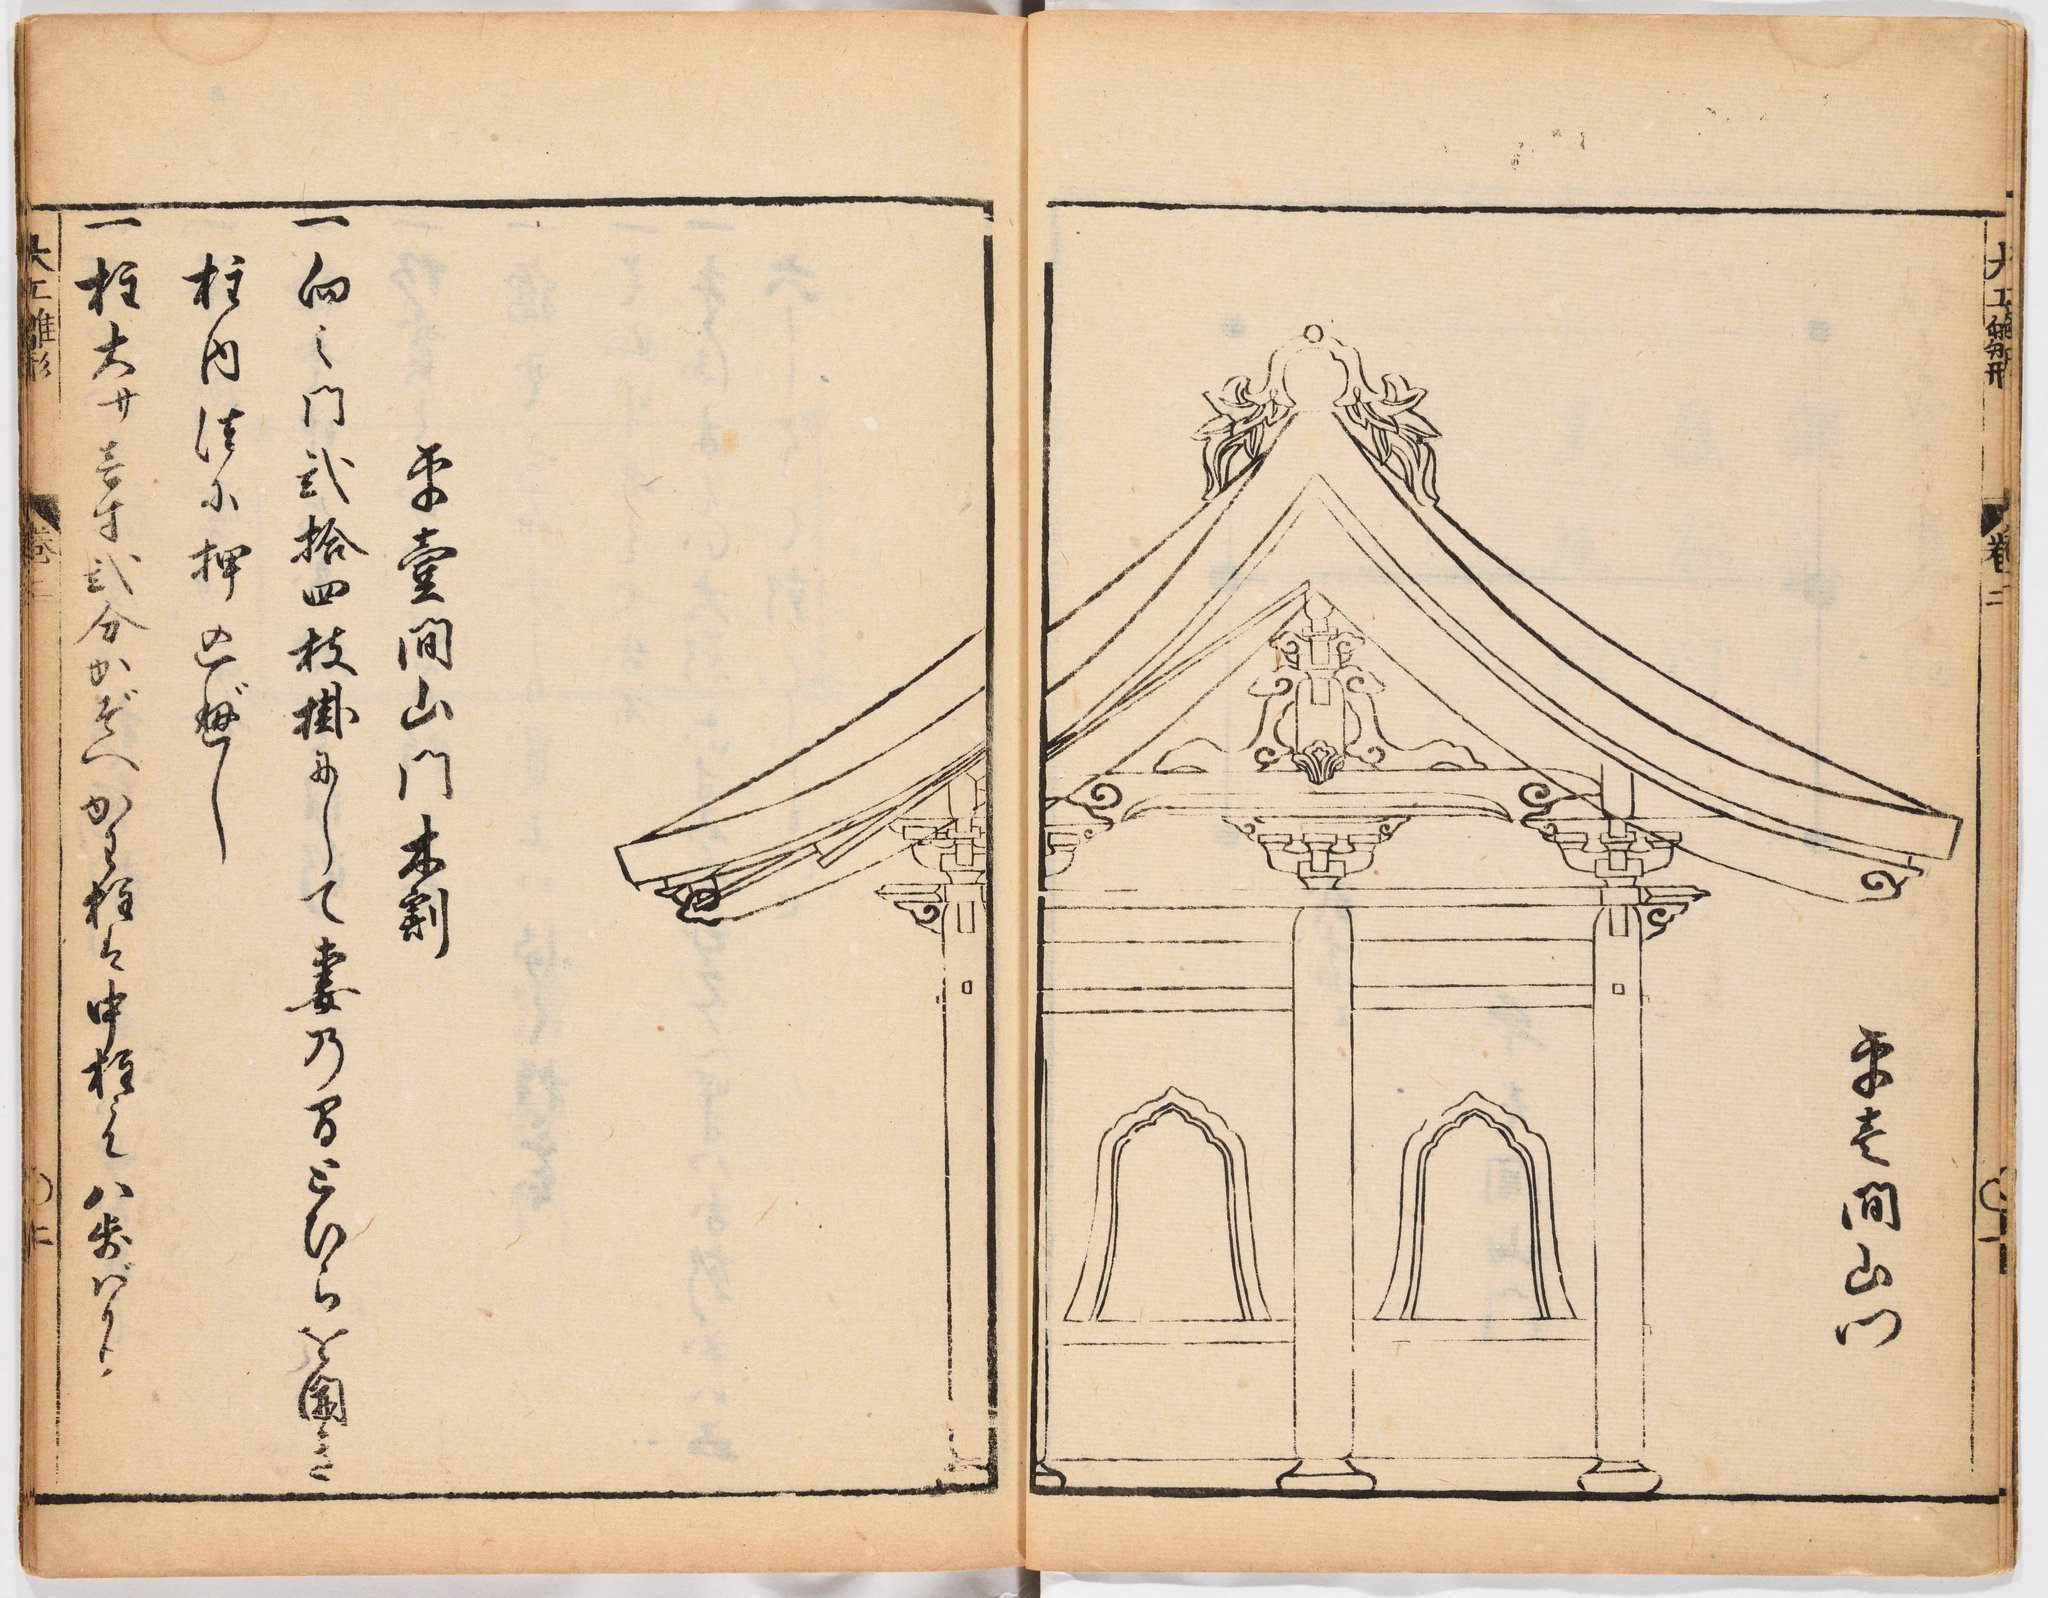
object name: illustrated book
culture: japanese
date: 1893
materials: ink, paper